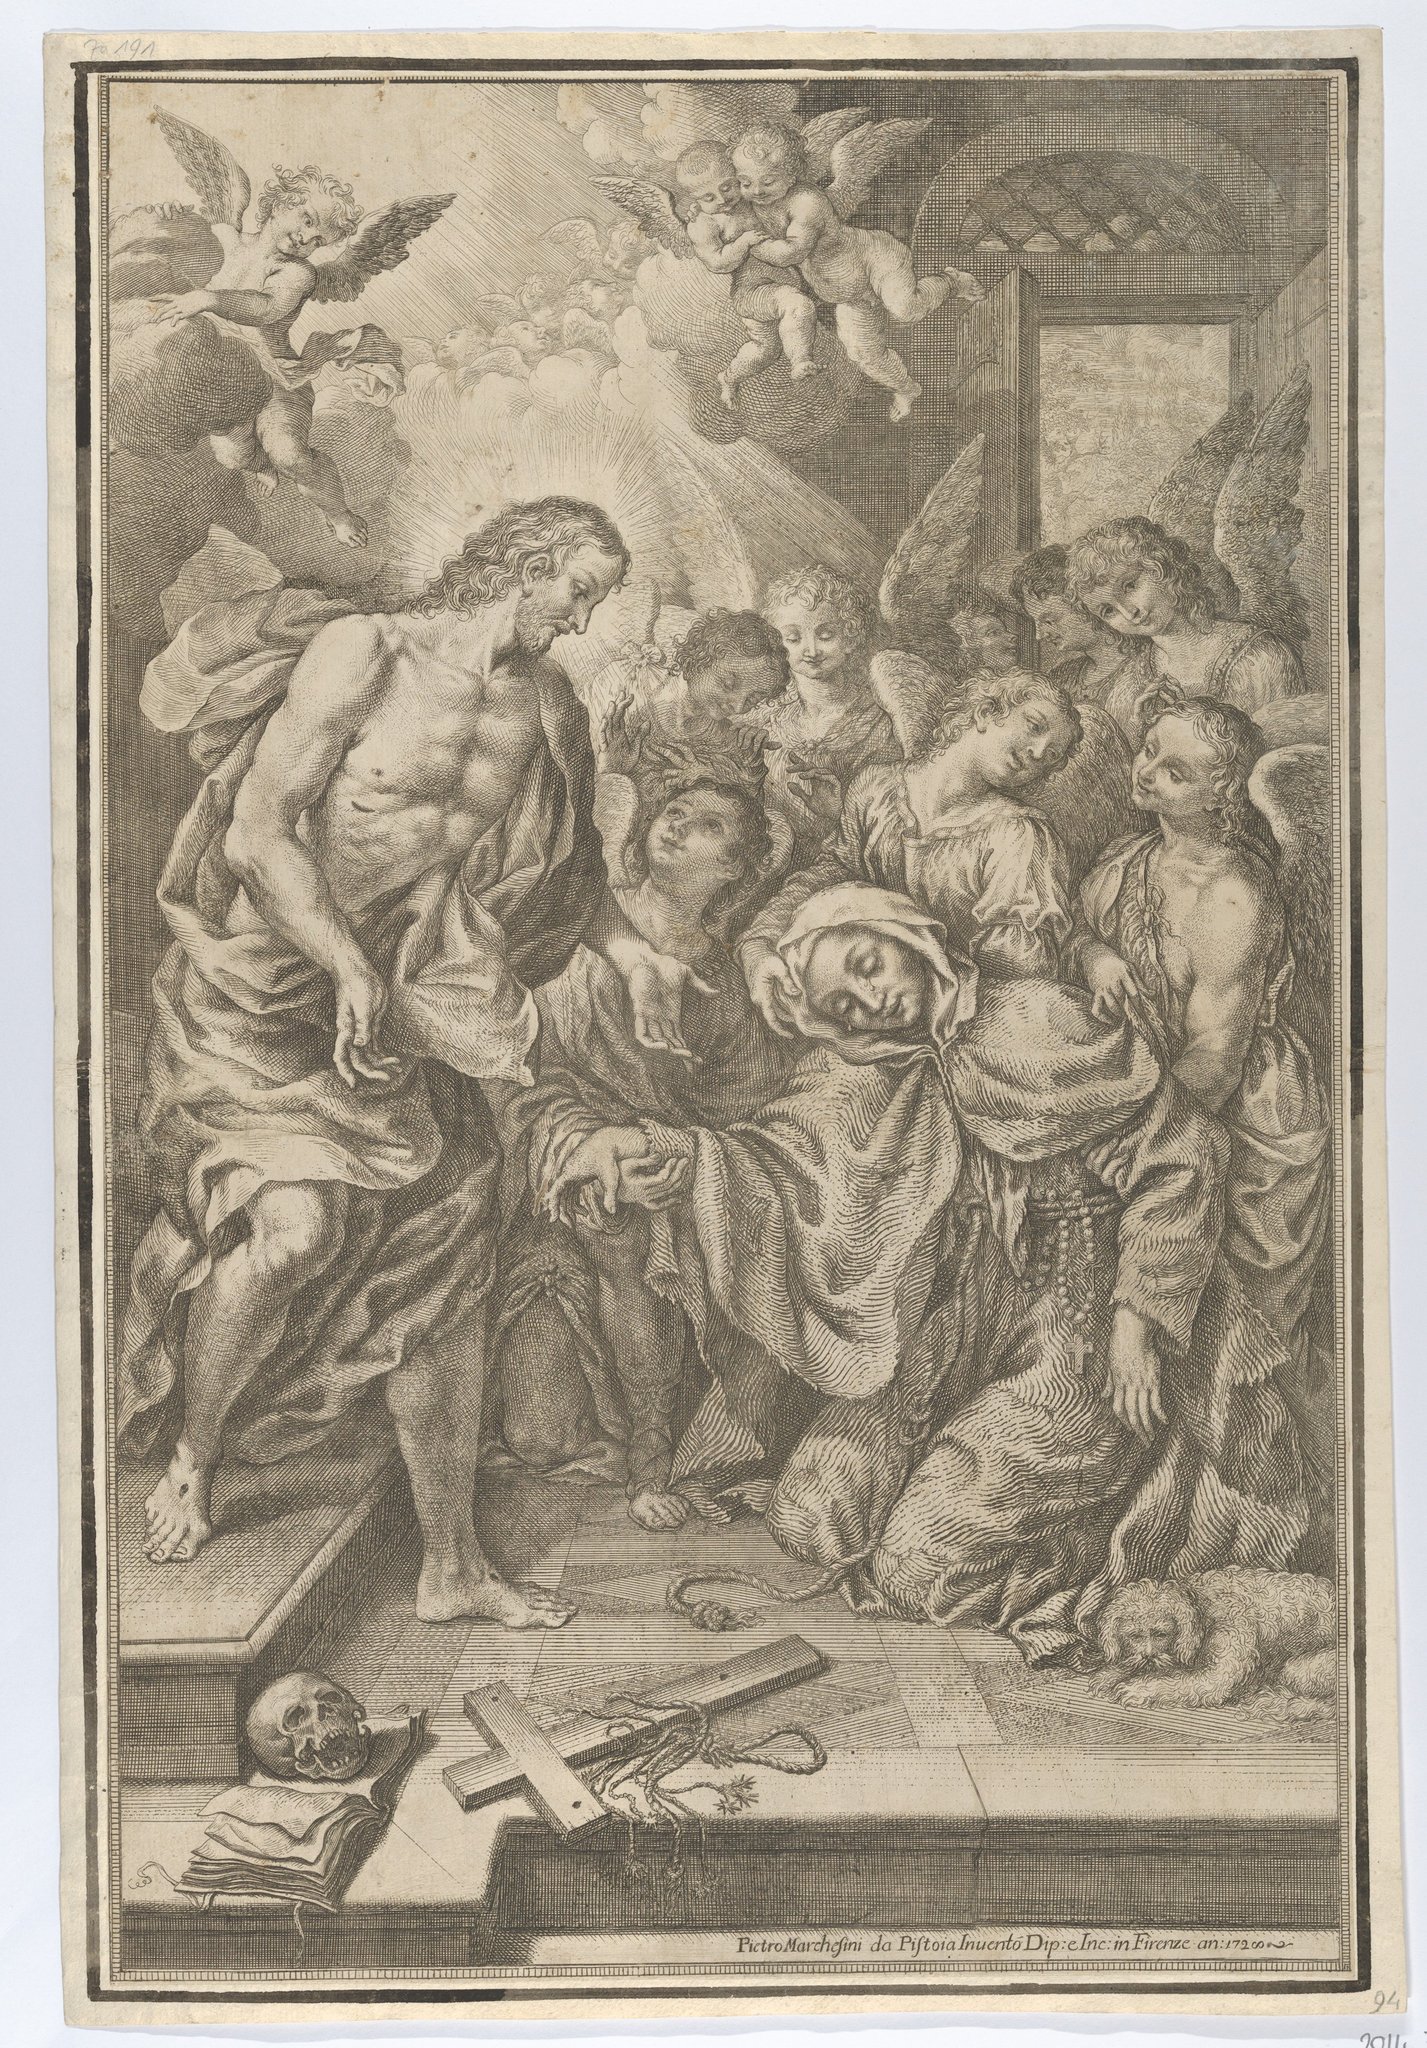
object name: print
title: Christ appearing to Saint Margaret of Cortona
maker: pietro marchesini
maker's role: artist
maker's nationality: italian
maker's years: 1692-1757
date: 1728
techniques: etching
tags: women,angels,christ,cross,saints